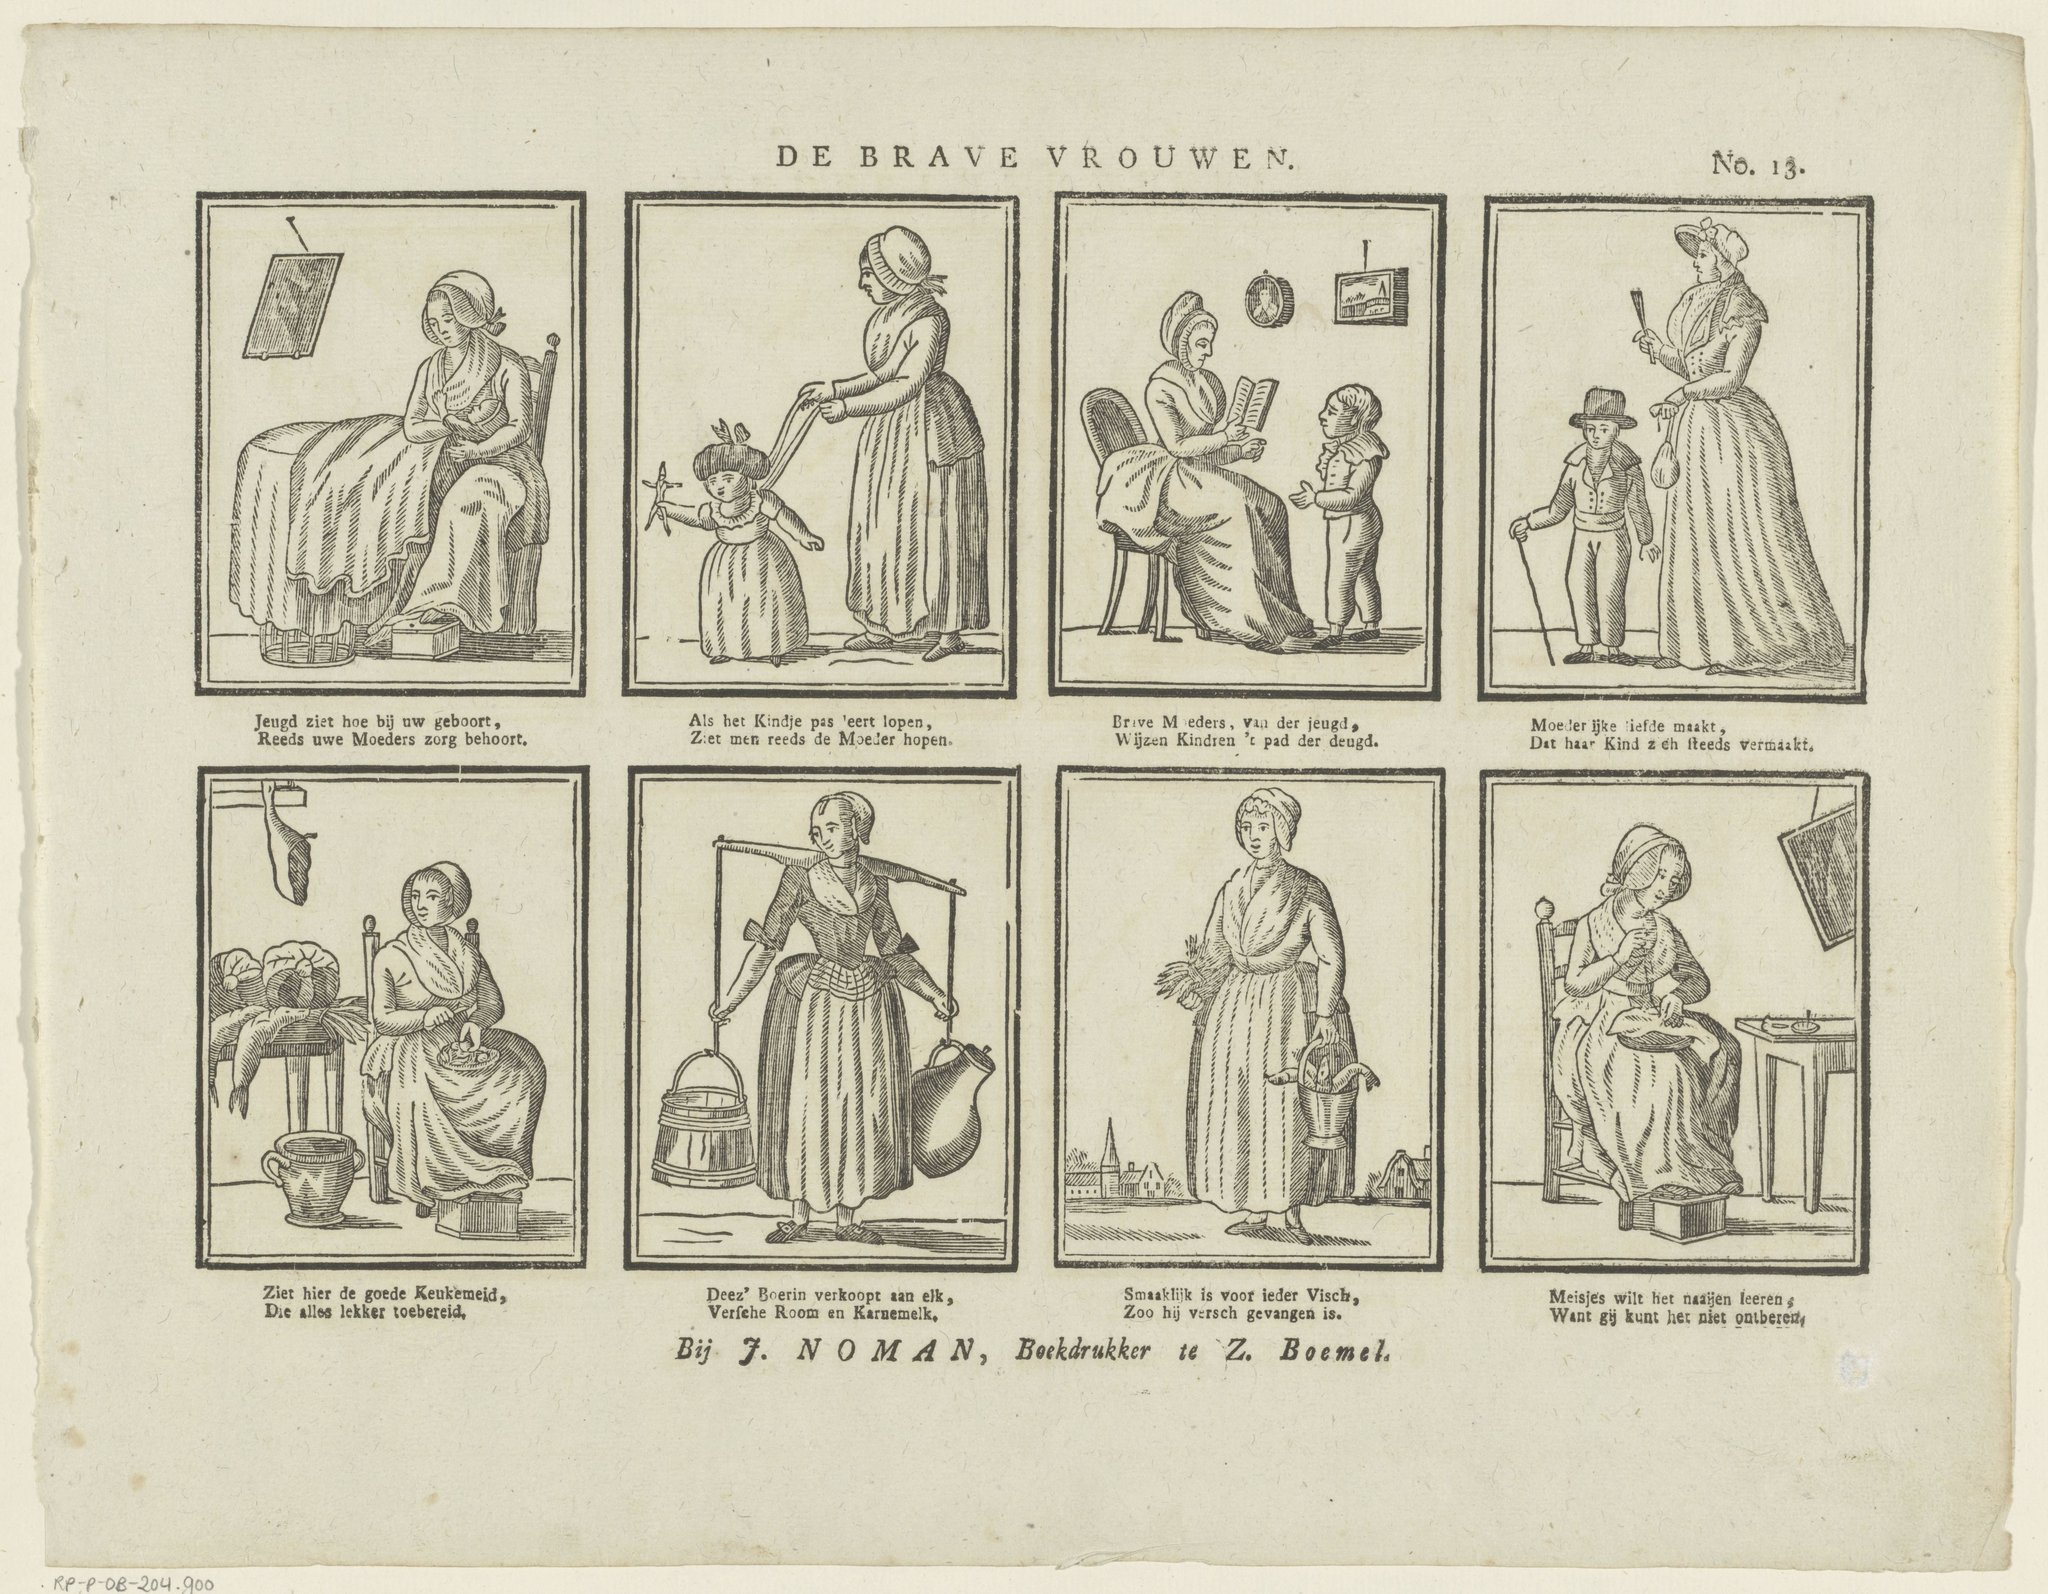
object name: popular print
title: De brave vrouwen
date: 1806-1830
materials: paper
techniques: letterpress printing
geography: netherlands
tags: household chores, kitchen-maid, kitchen servant, sewing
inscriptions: collector's mark: Lugt 2760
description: Blad met 8 voorstellingen van vrouwen die huishoudelijke taken uitvoeren, zoals voor de kinderen zorgen en naaien. Onder elke afbeelding een tweeregelig vers. Genummerd rechtsboven: No. 13.